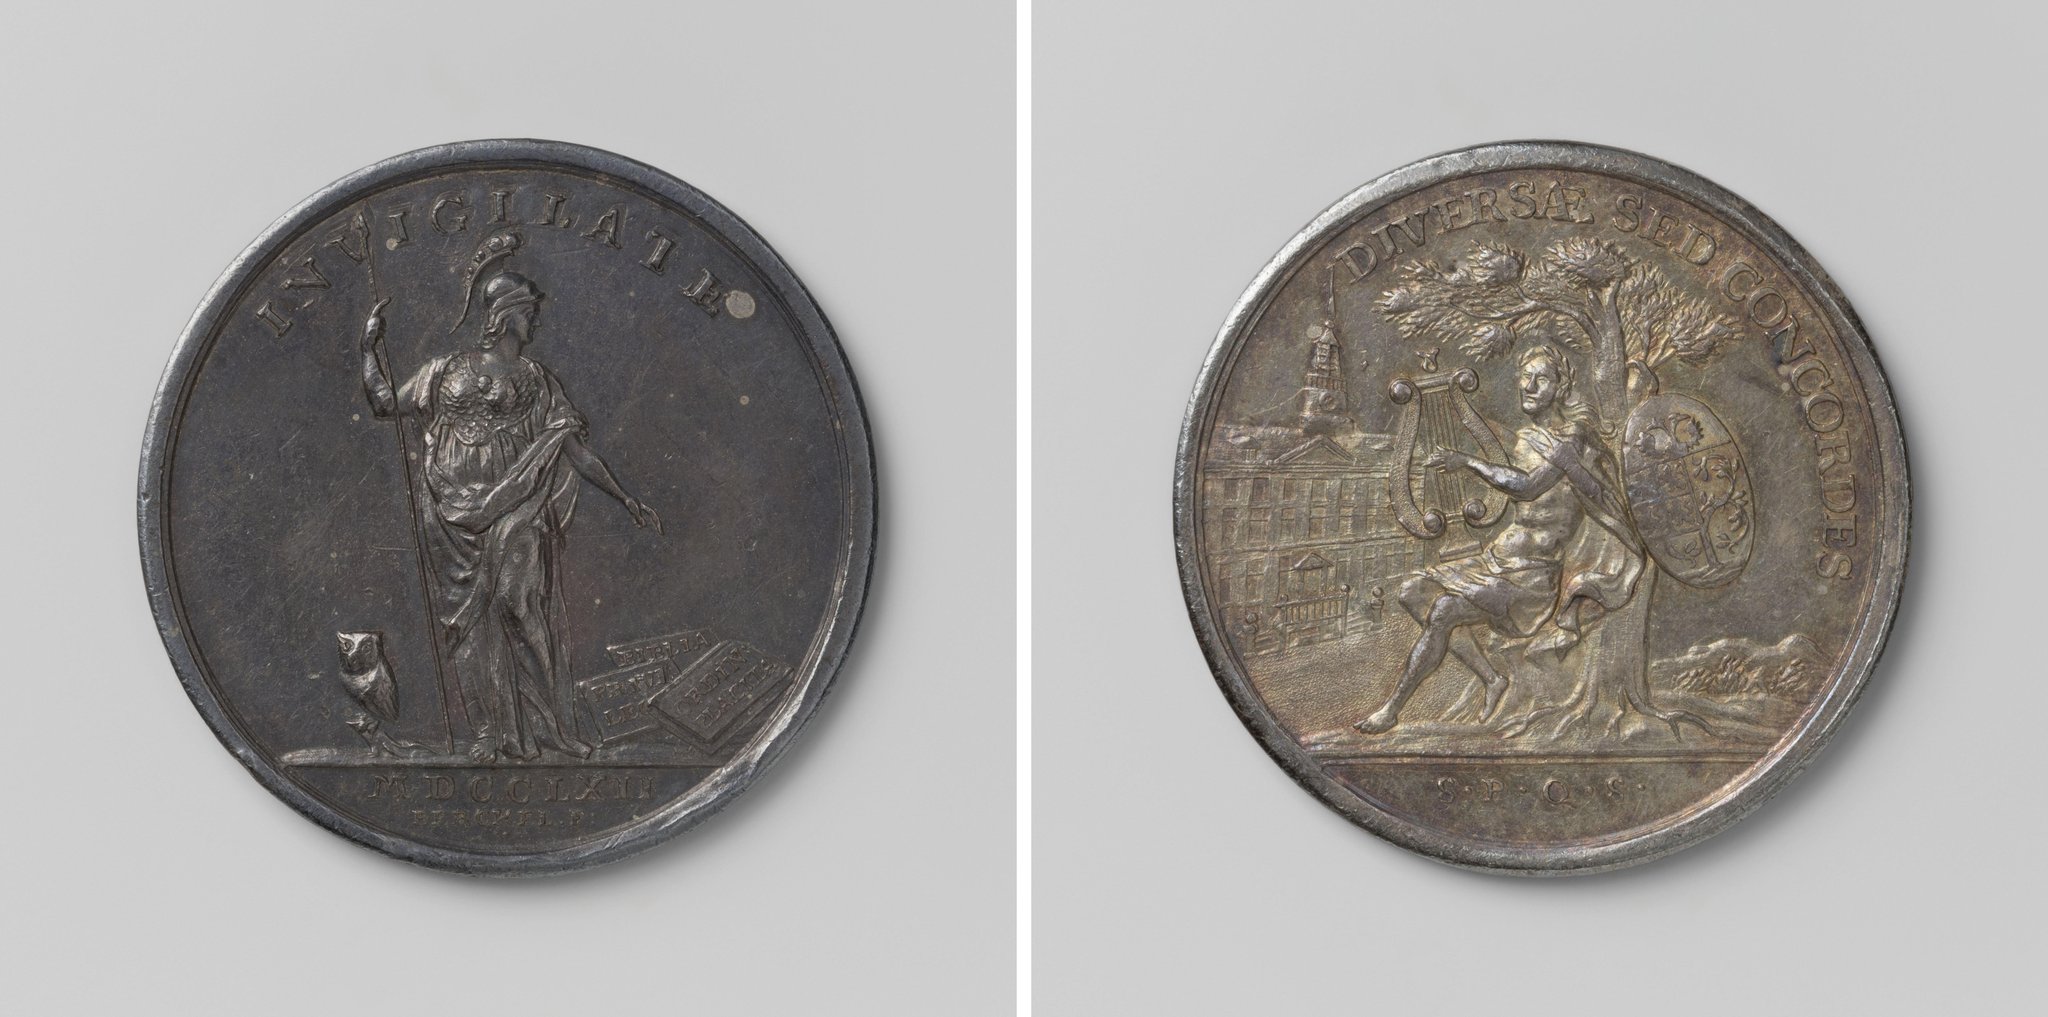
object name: council medal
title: Vroedschapspenning van de stad 's-Hertogenbosch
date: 1762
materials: silver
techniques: striking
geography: den bosch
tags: den bosch